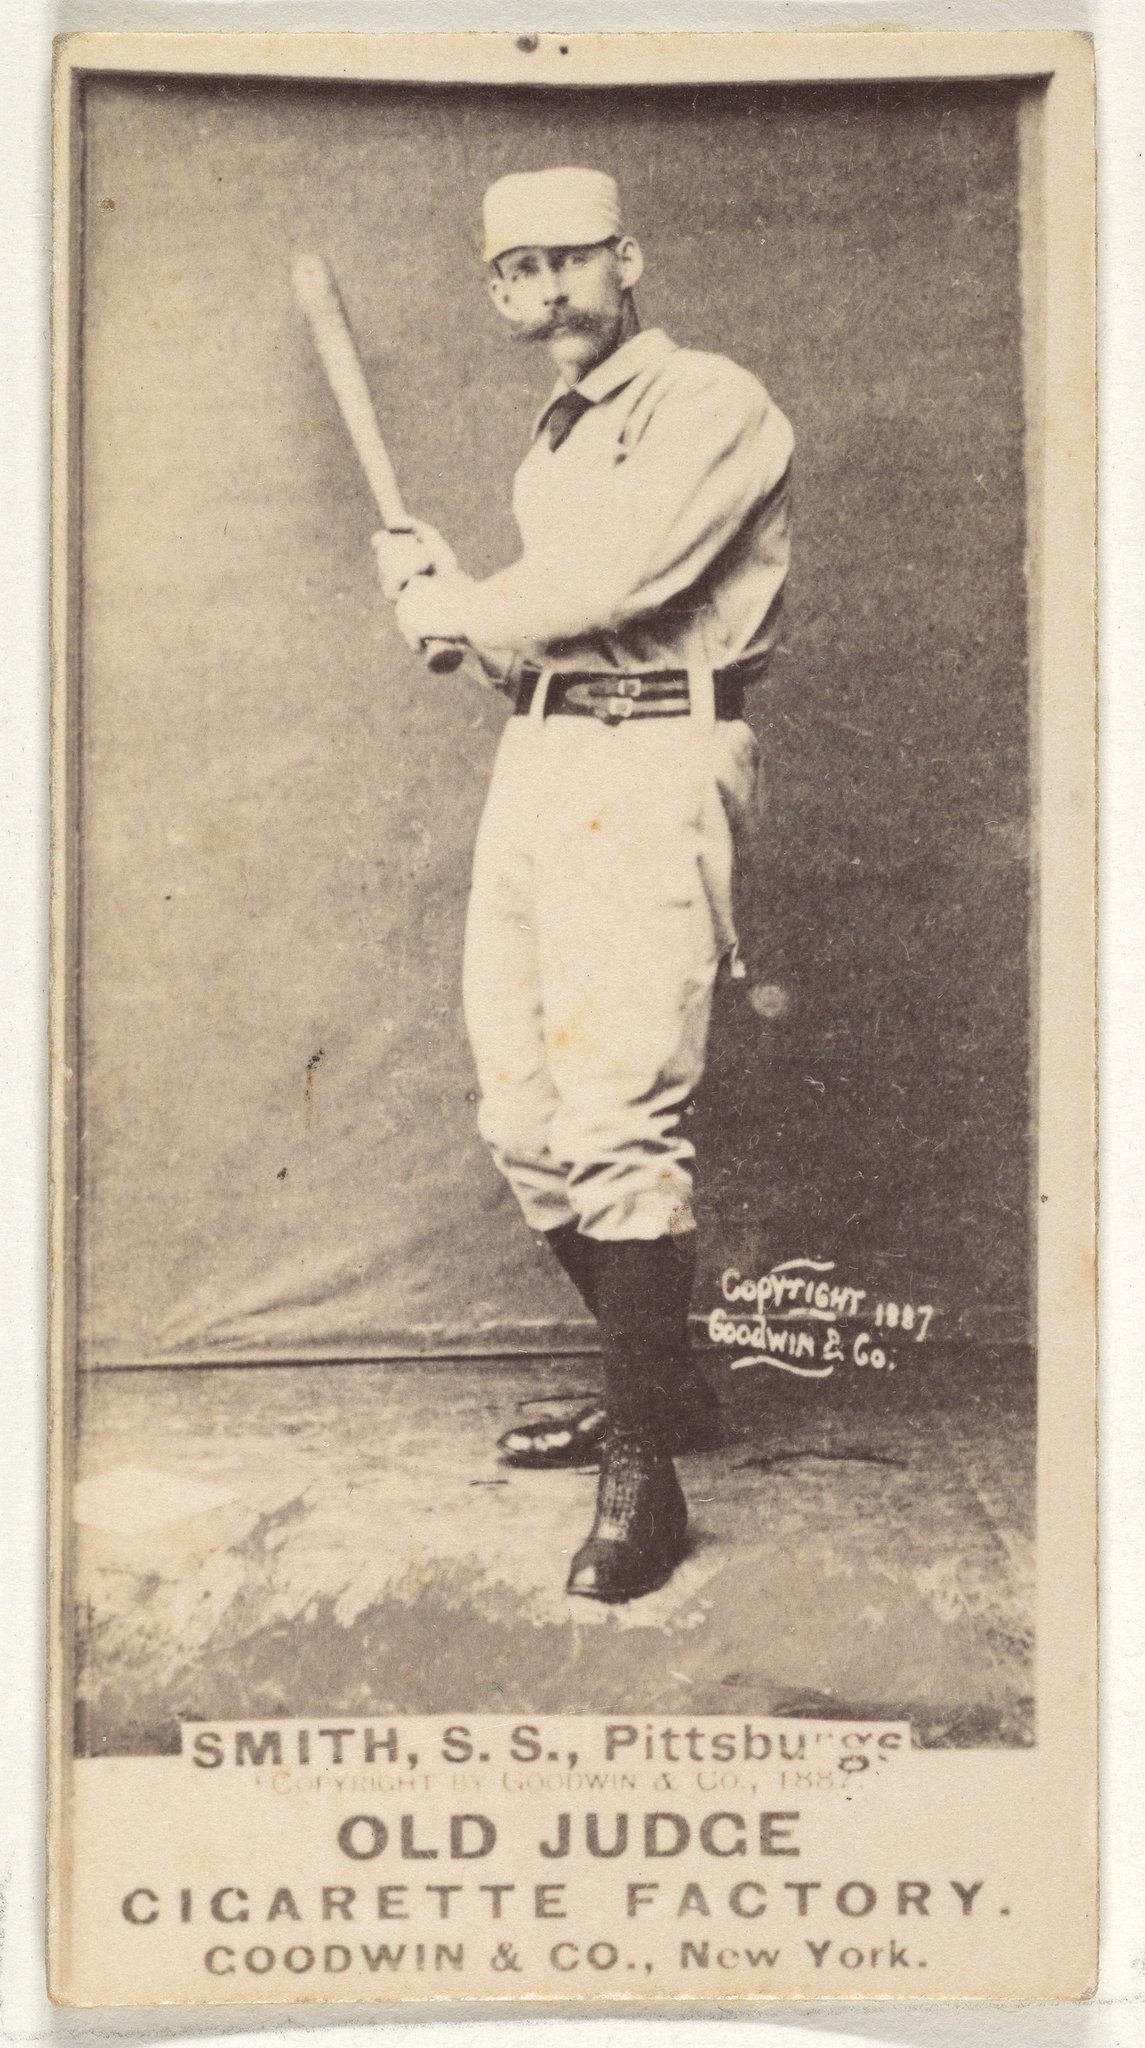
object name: baseball card, photograph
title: Charles Marv "Pop" Smith, Shortstop, Pittsburgh, from the Old Judge series (N172) for Old Judge Cigarettes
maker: goodwin & company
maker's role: publisher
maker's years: 1850-1950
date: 1887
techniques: albumen silver print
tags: men,portraits,baseball,athletes